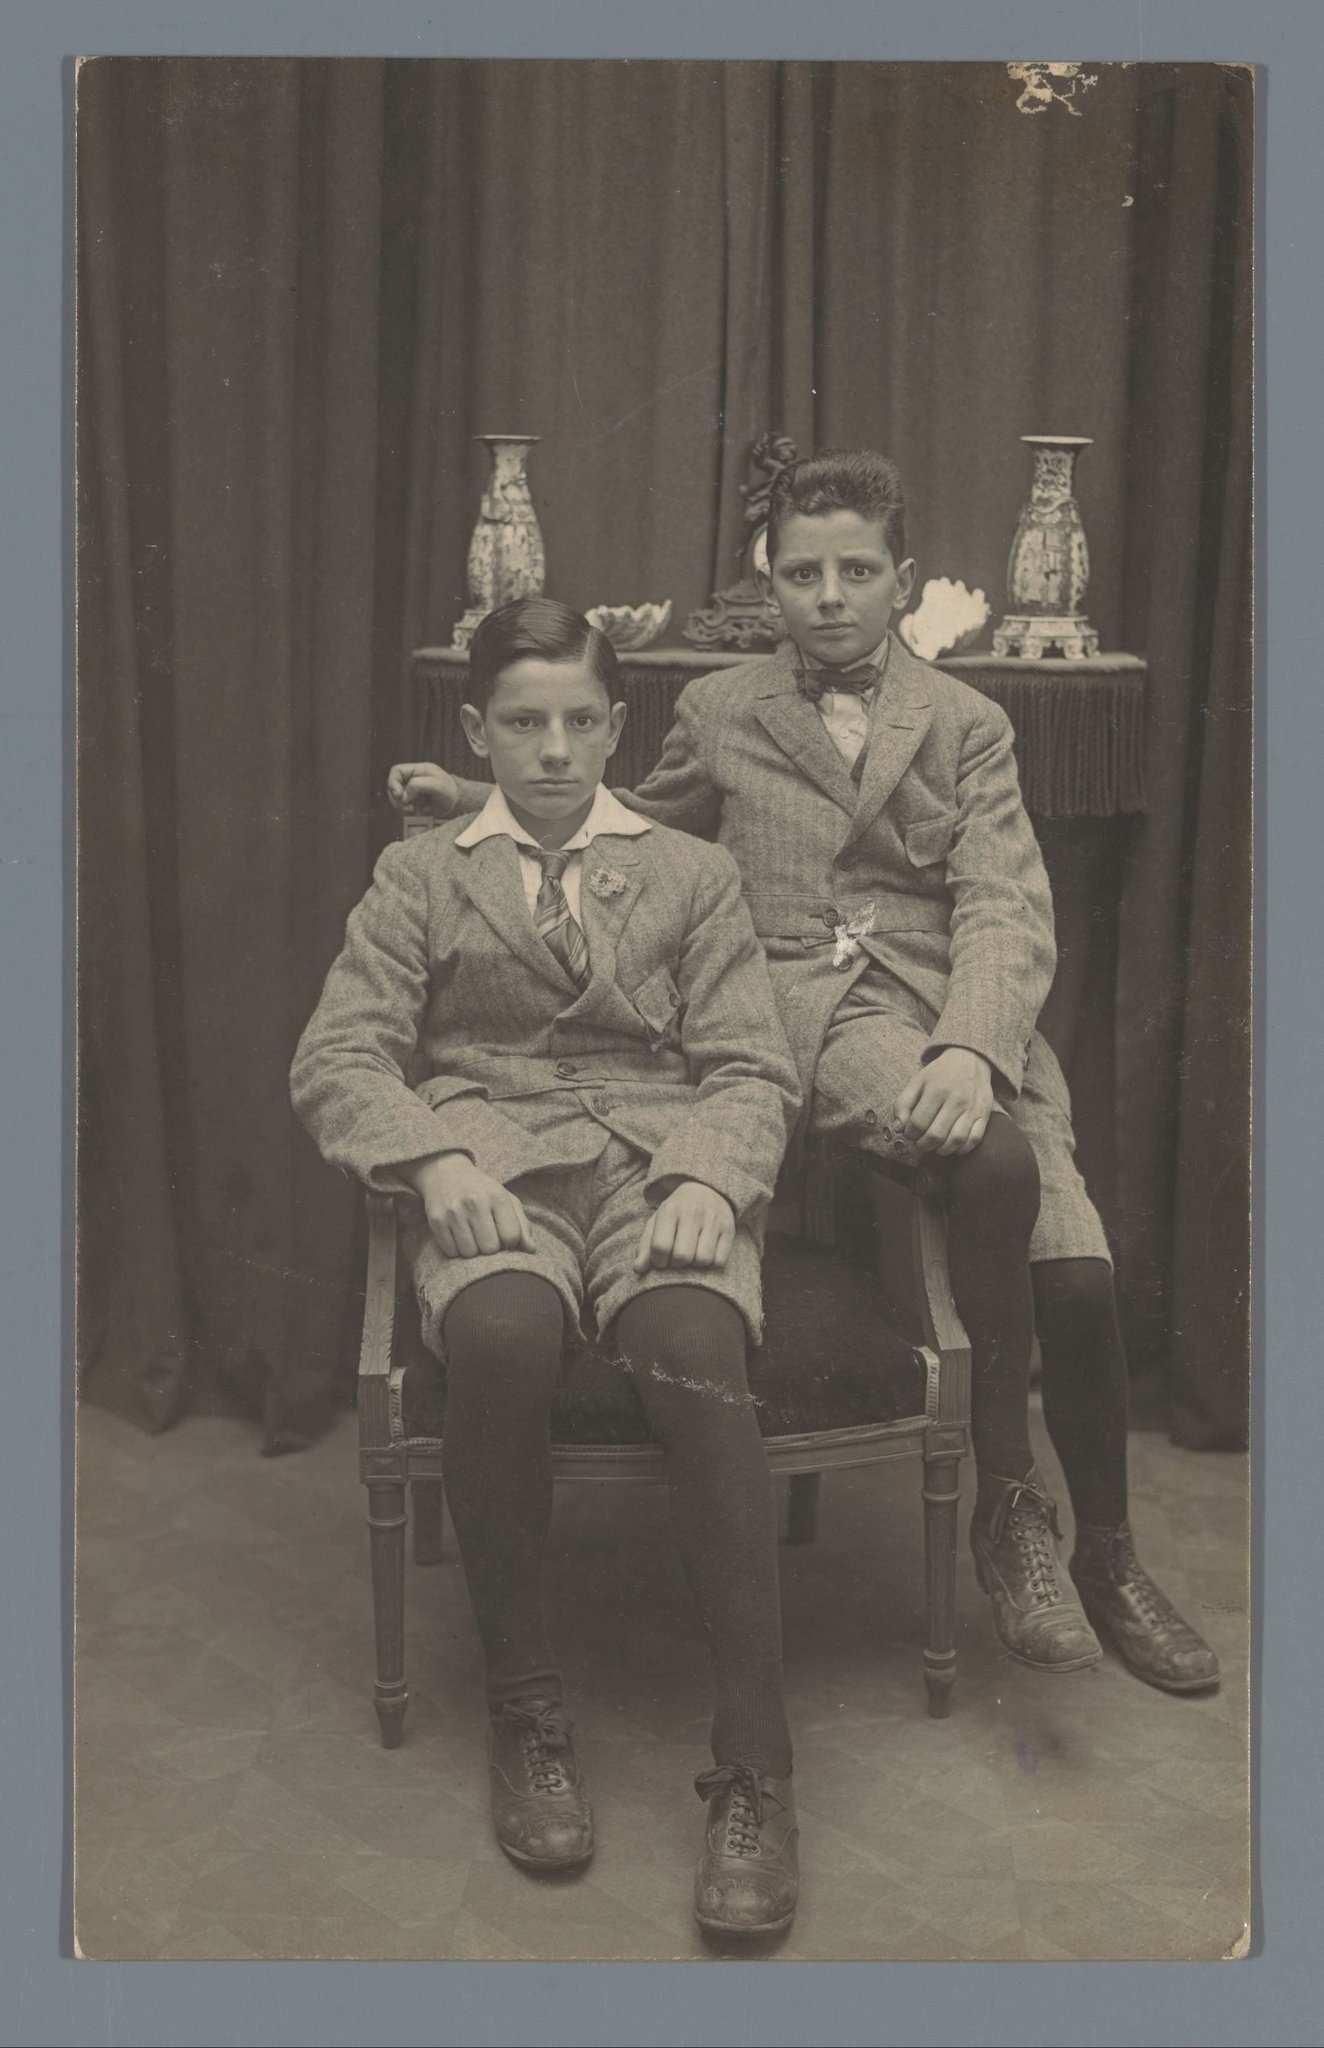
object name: ansichtkaart, prentbriefkaart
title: Portret van twee onbekende jongens, met op de achtergrond Chinese vazen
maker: Anonymous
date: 1923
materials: photographic support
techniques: gelatin silver print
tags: boy (child between toddler and youth), container of ceramics: jar, jug, pot, vase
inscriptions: inscription: ‘17-6-'23’